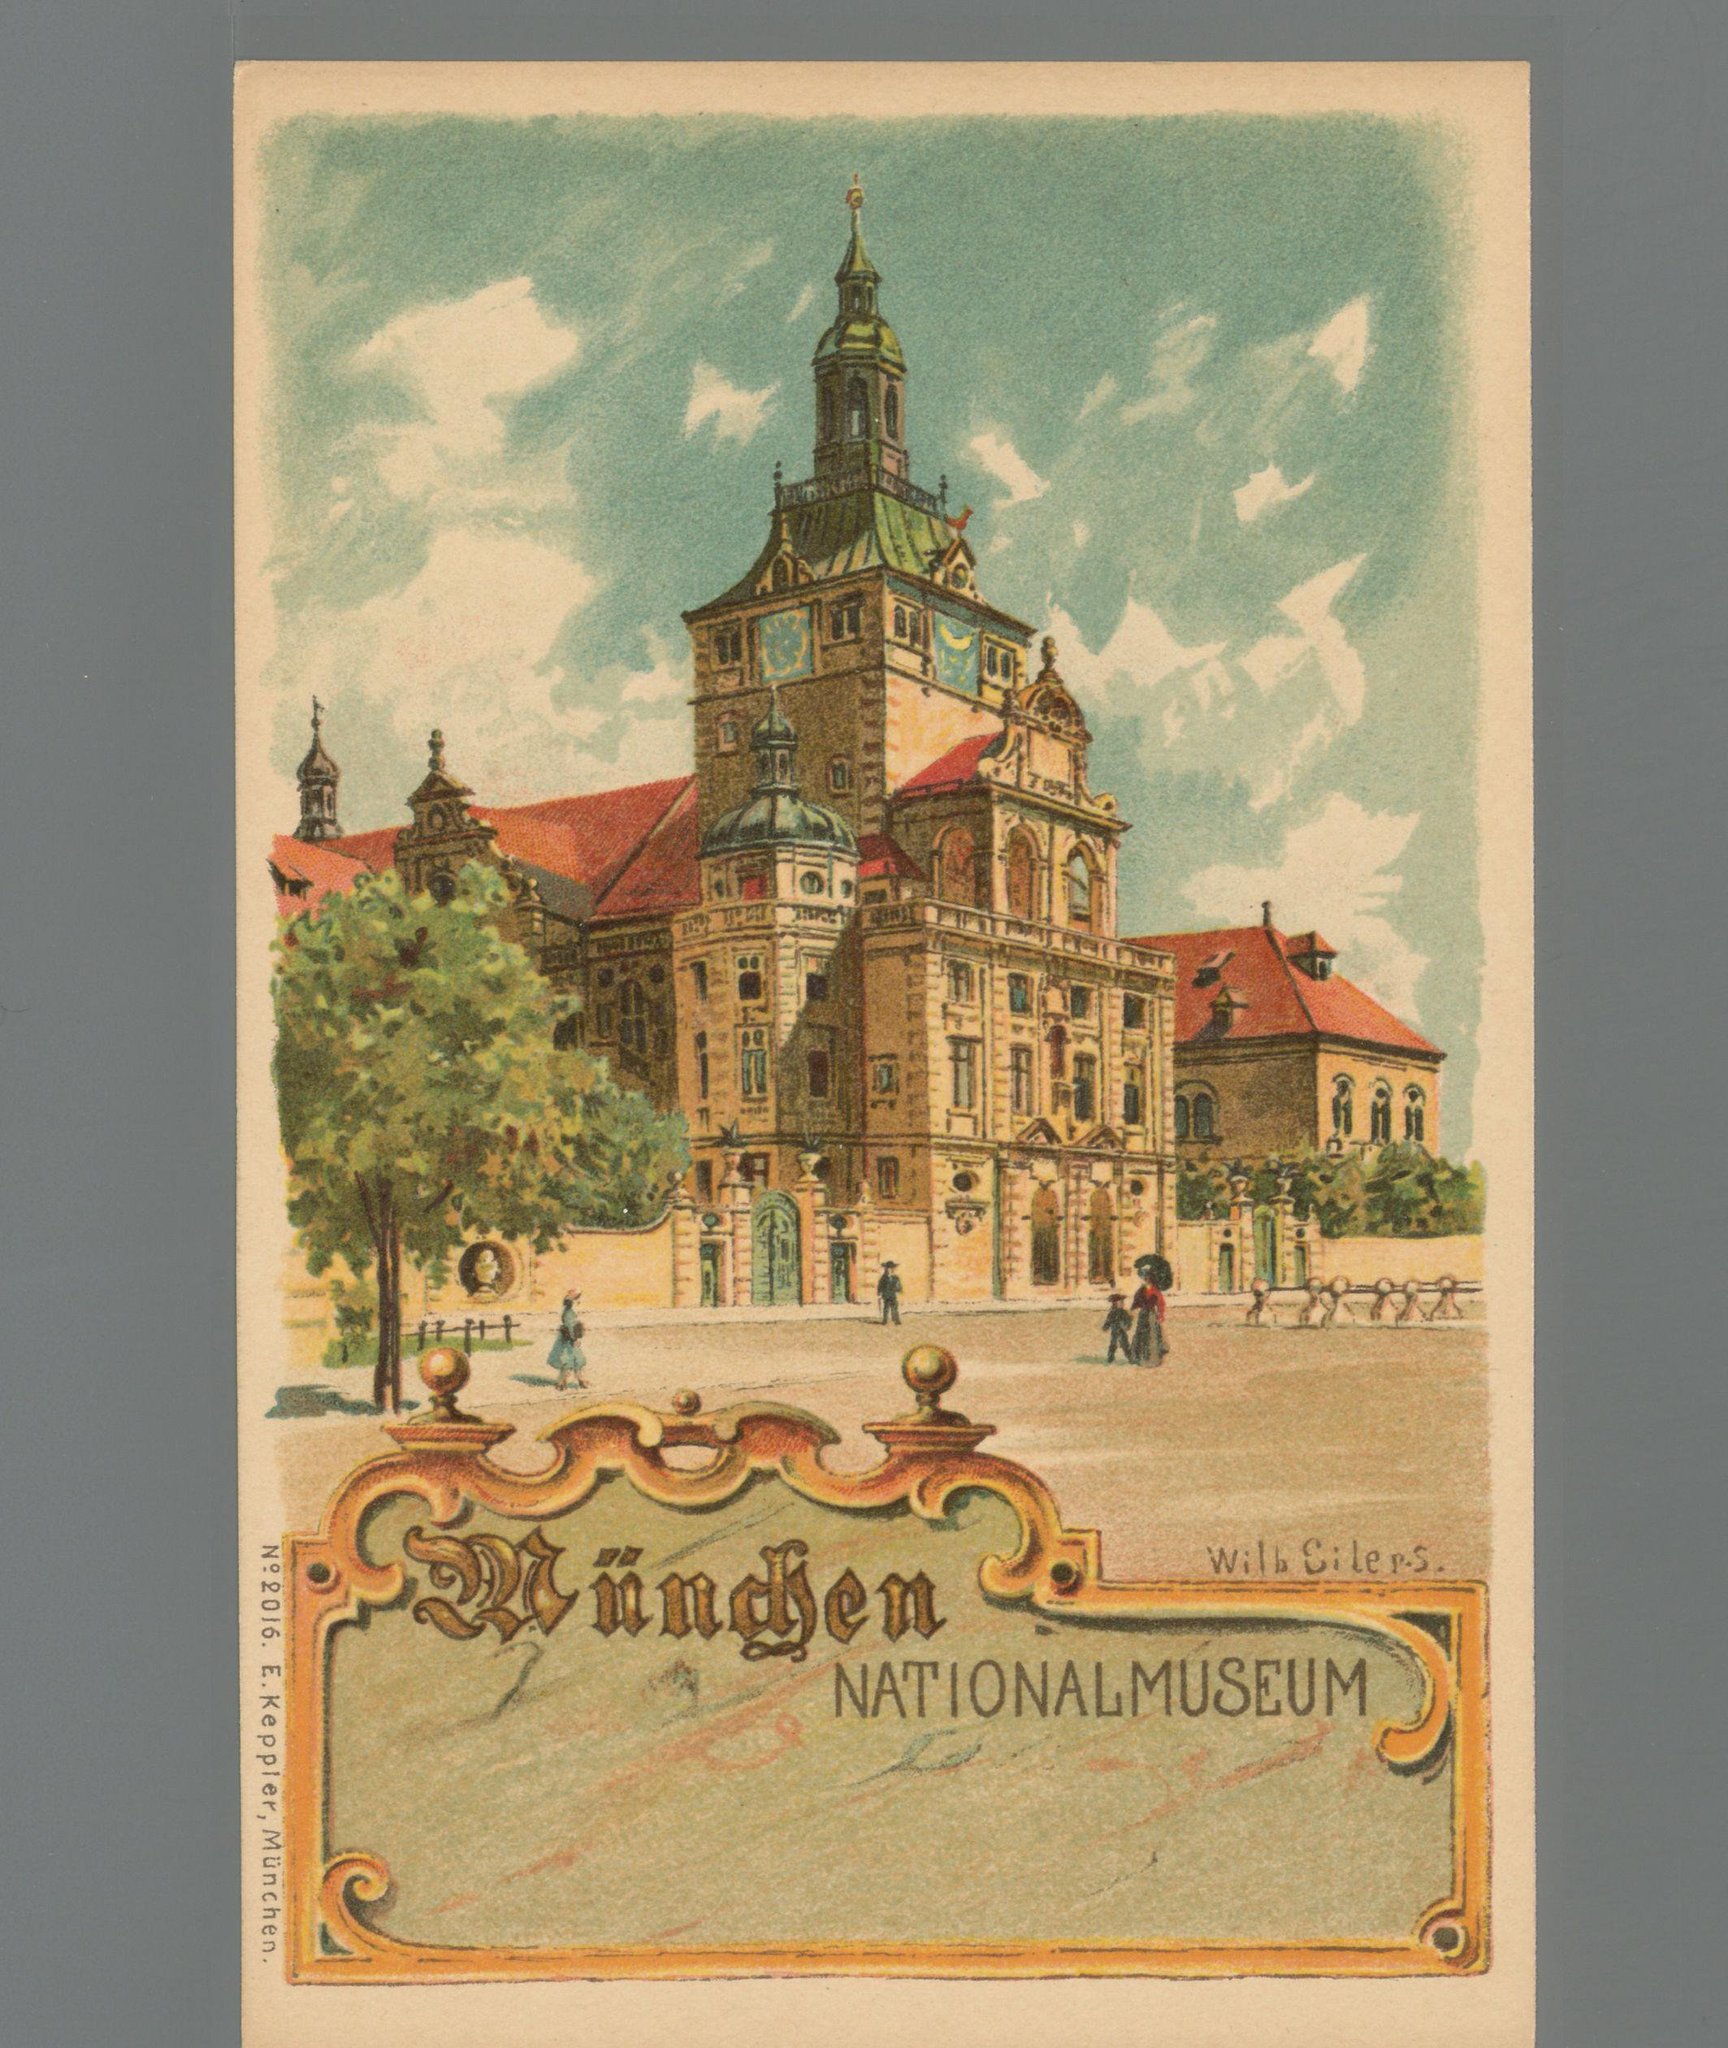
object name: print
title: München. Nationalmuseum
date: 1885-1905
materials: cardboard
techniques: lithograph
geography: munich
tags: permanent exhibition, museum